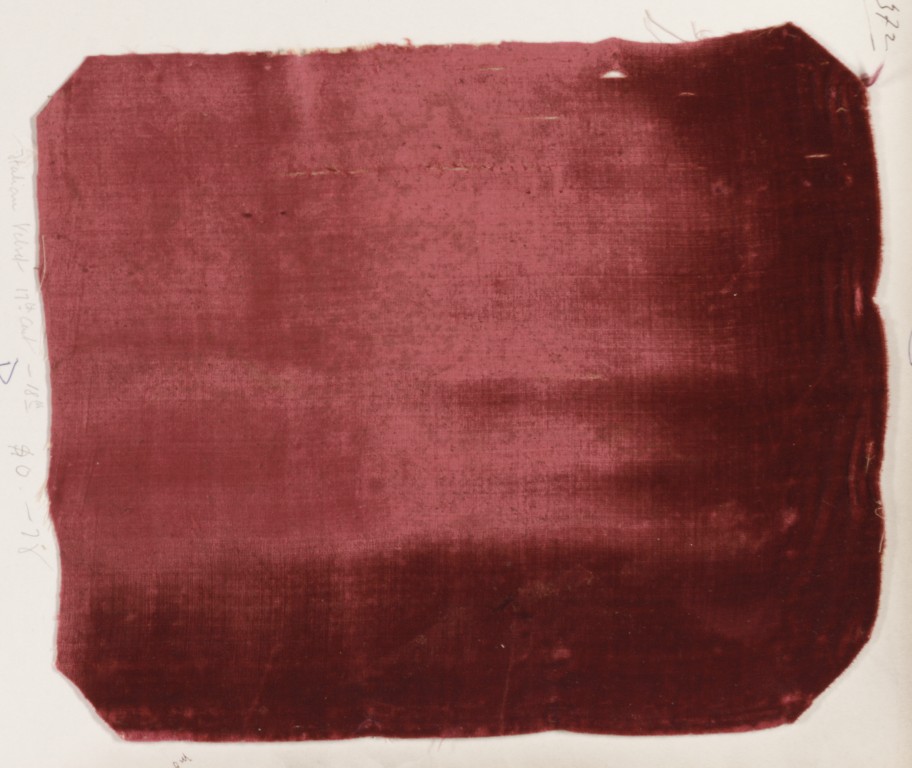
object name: fragment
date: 1601-1800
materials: silk